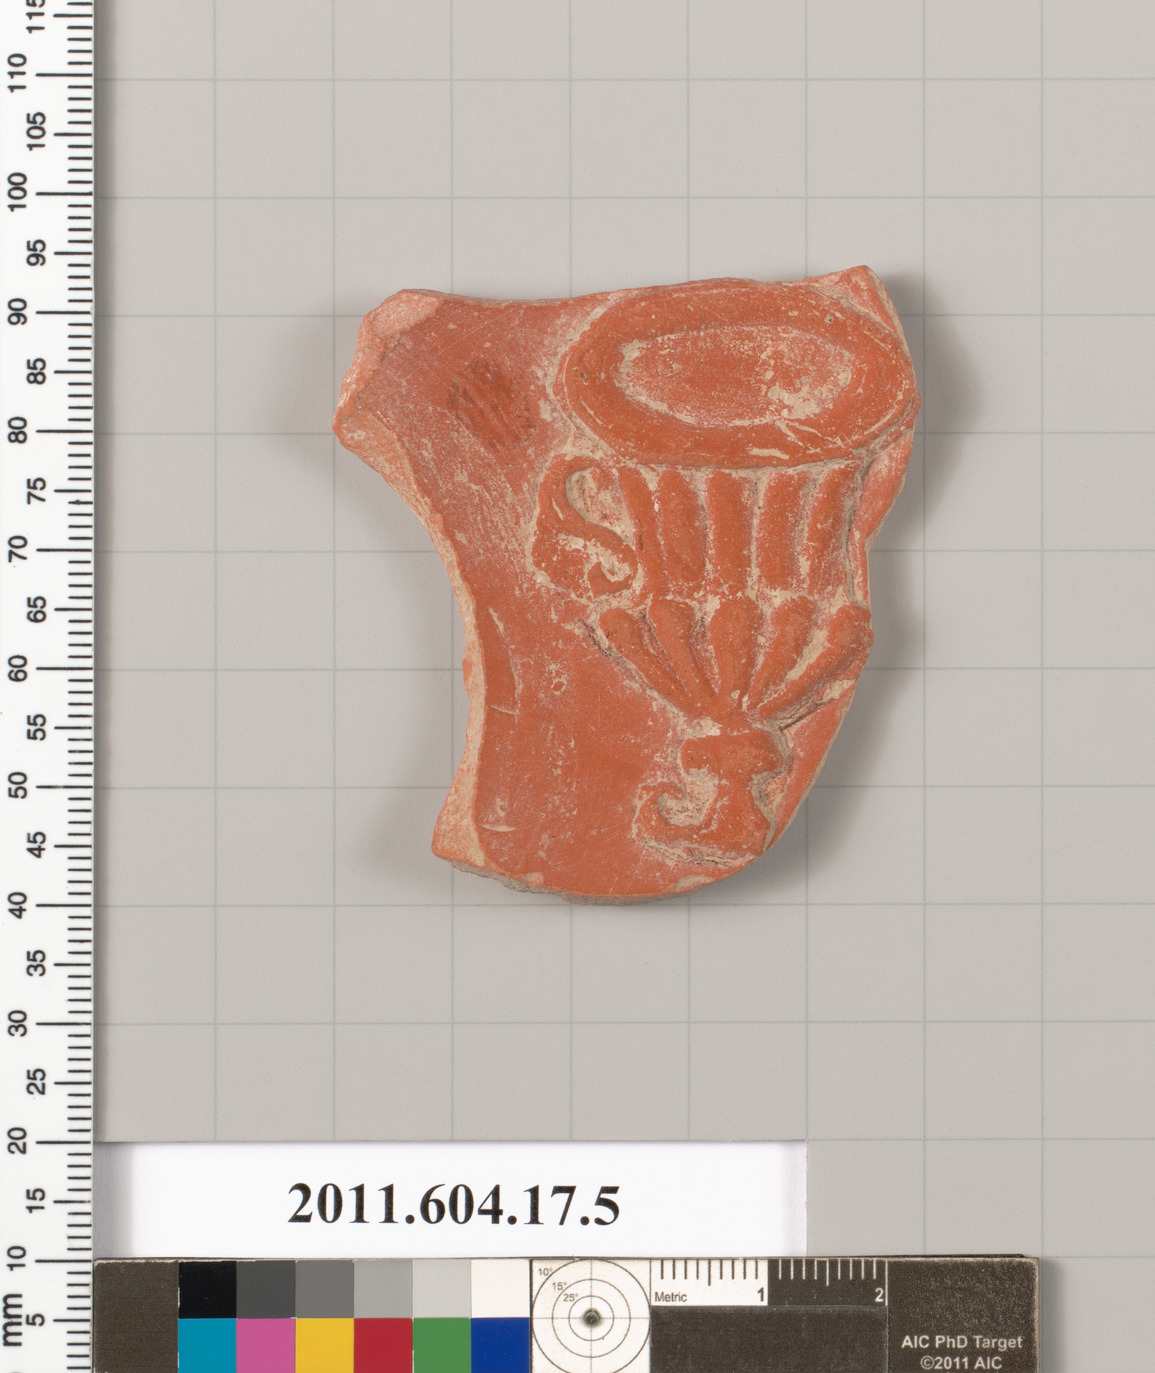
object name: plate fragment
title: Terracotta fragments of a plate?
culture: roman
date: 401-600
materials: terracotta